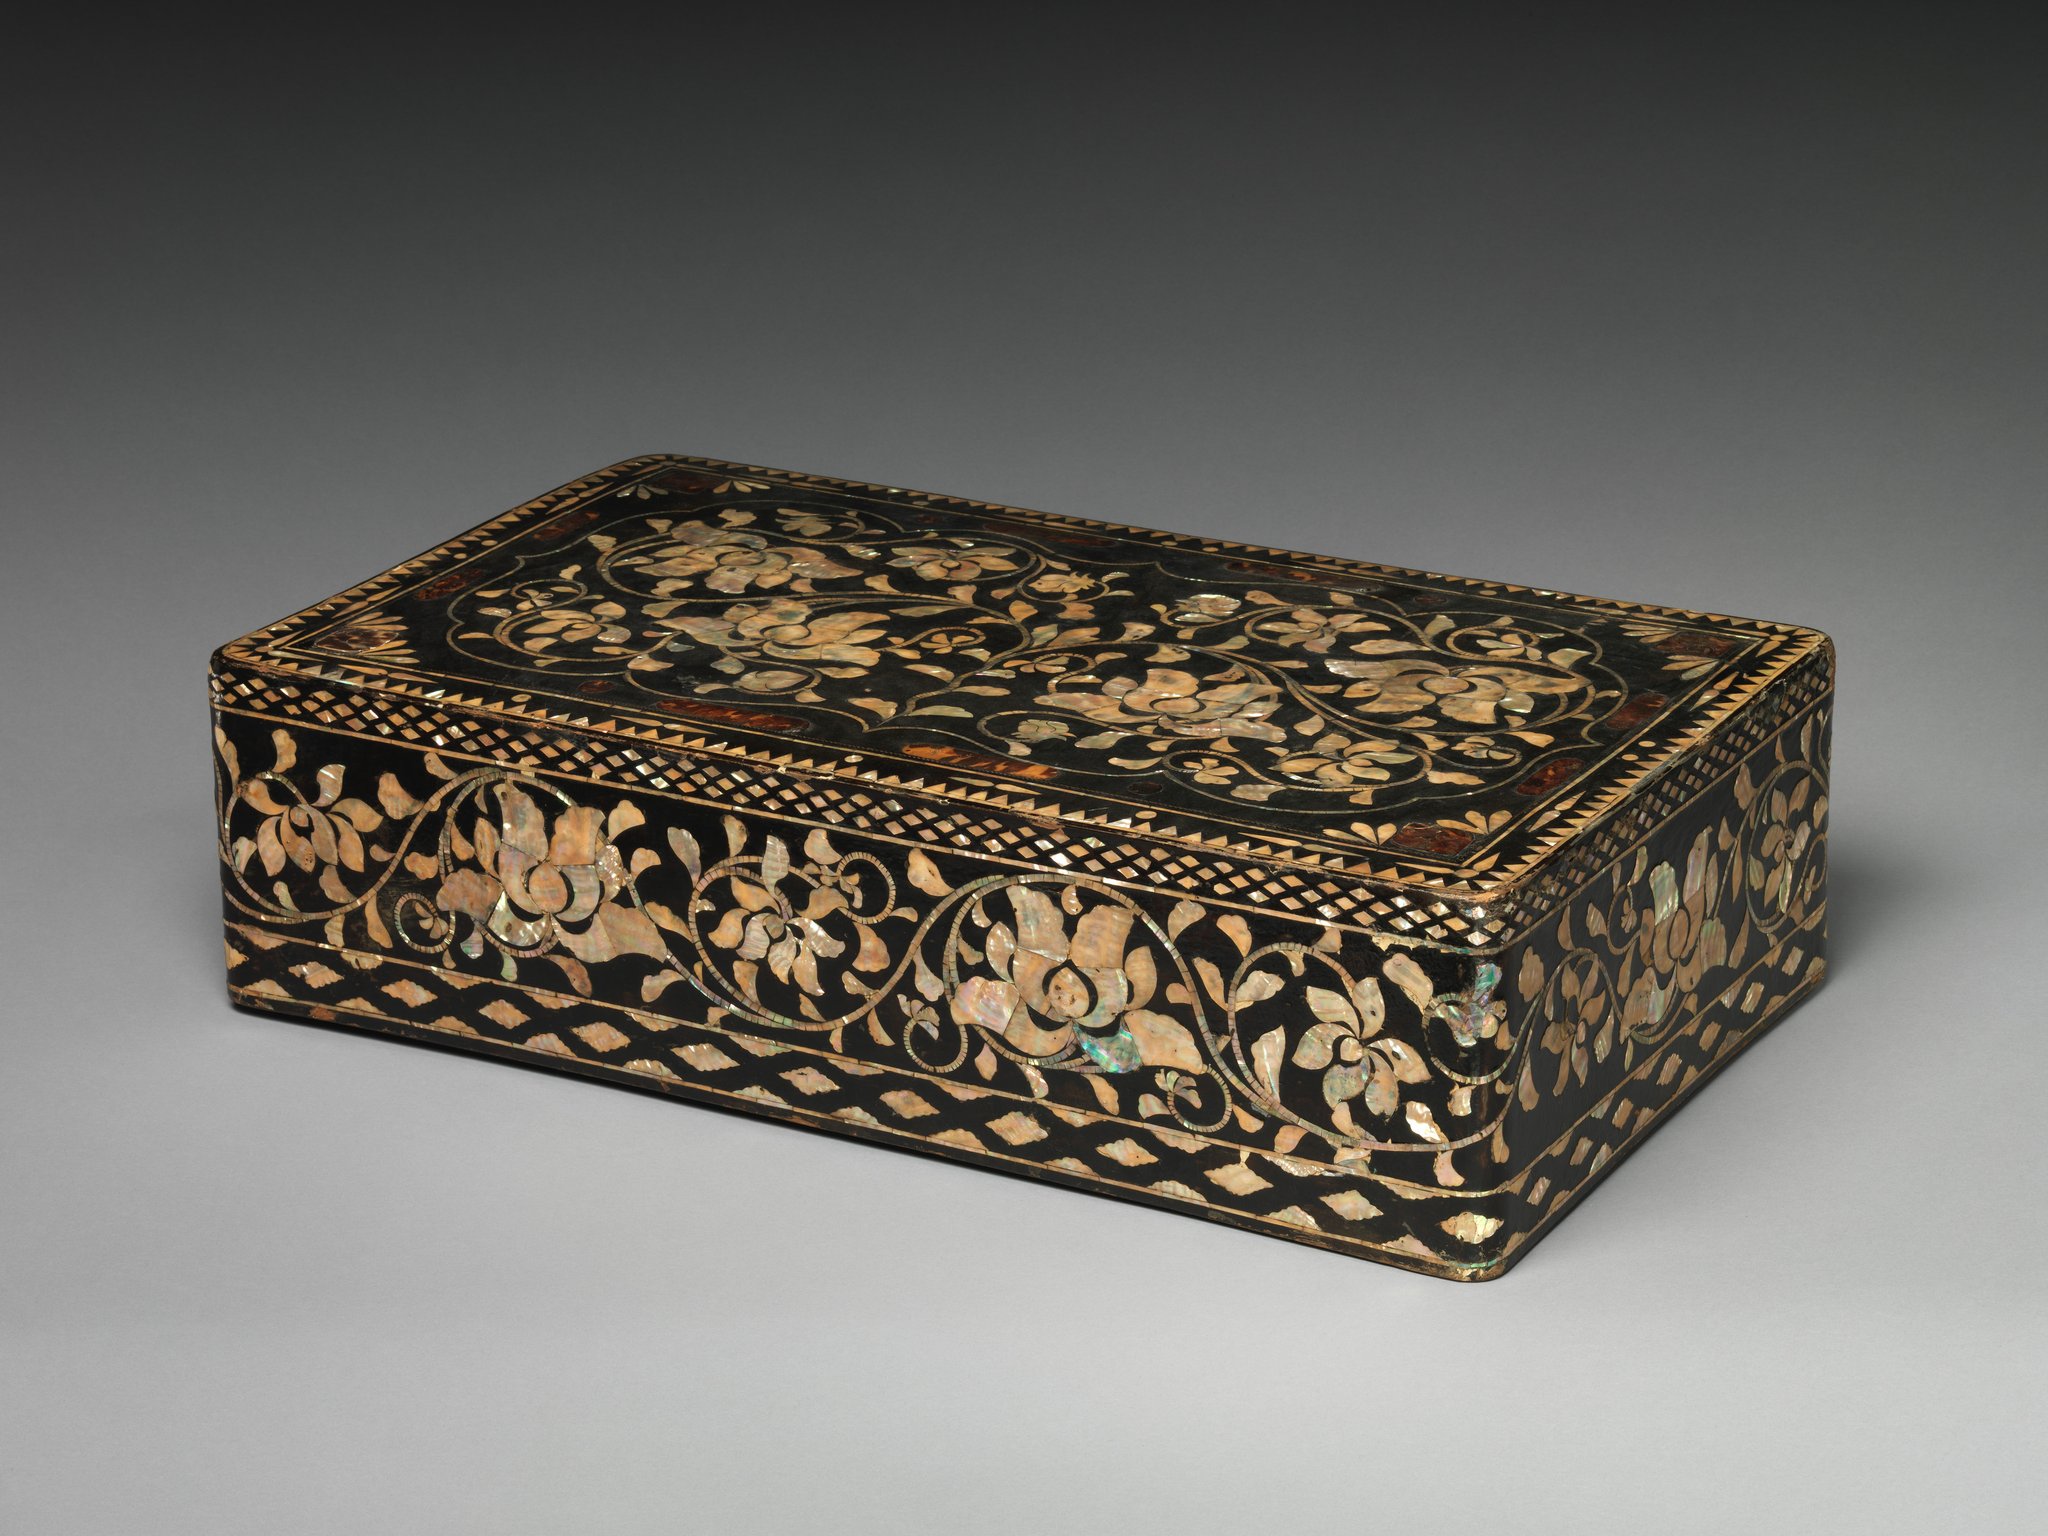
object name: clothing box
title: Clothing box decorated with peony scrolls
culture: korean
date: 1601-1700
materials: brass, lacquer, mother of pearl, shell, metal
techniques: inlay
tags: peonies